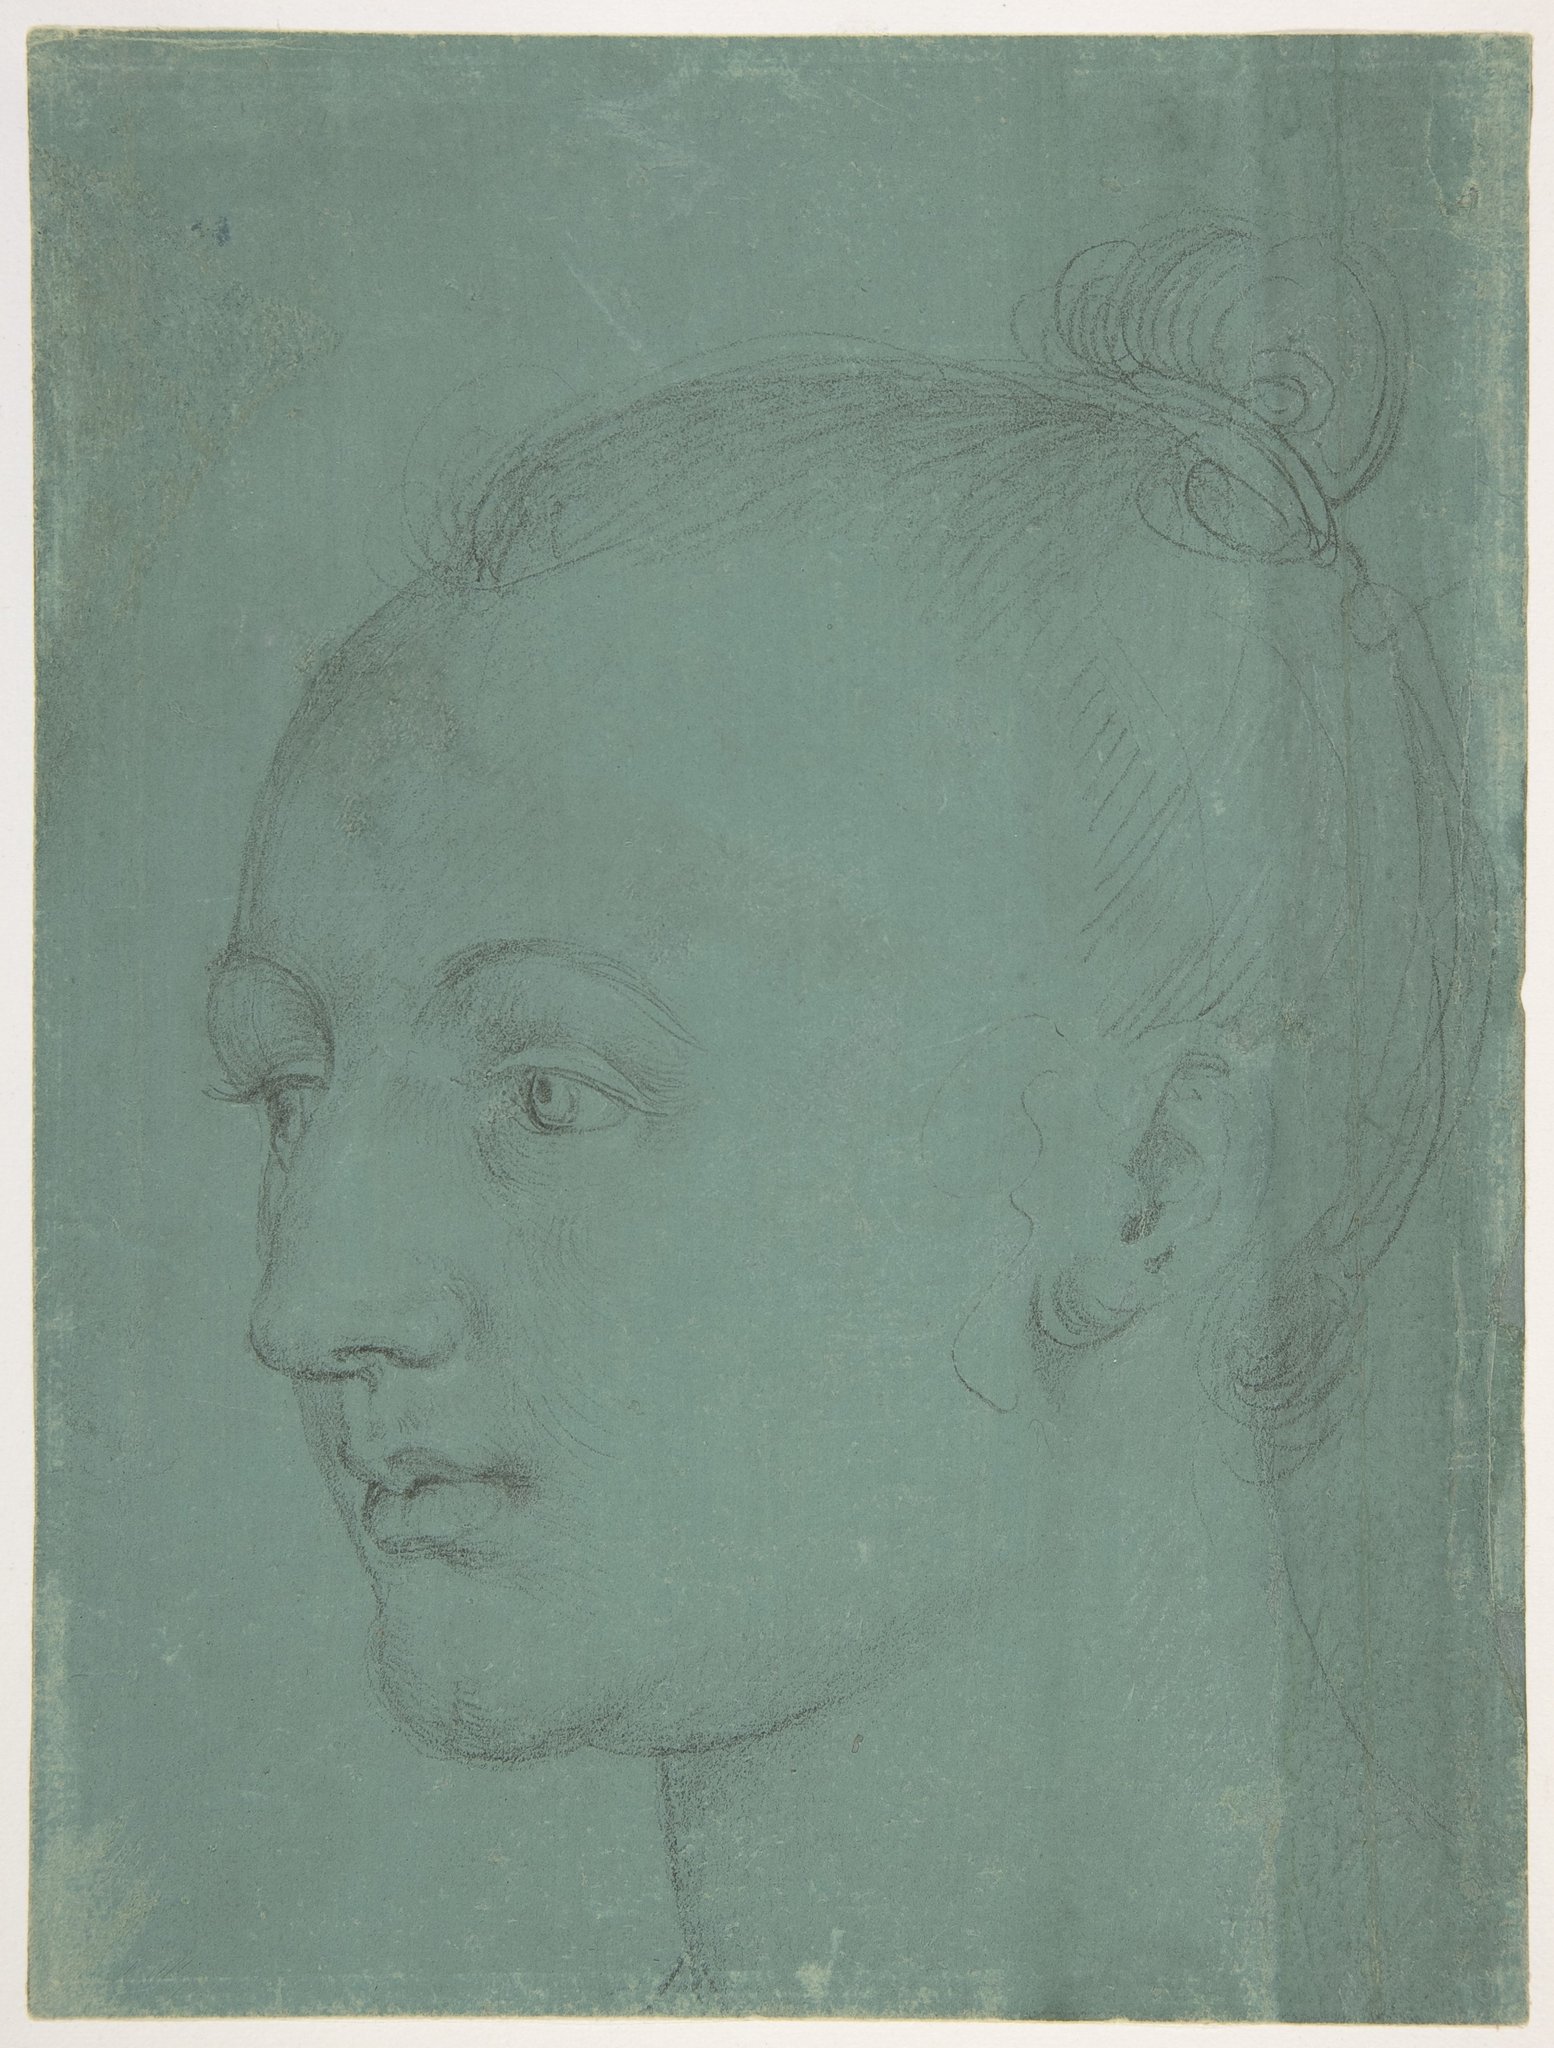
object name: drawing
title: Head of a Young Woman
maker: albrecht dürer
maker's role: artist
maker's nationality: german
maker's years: 1471-1528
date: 1522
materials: chalk, paper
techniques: highlighting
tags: heads,women